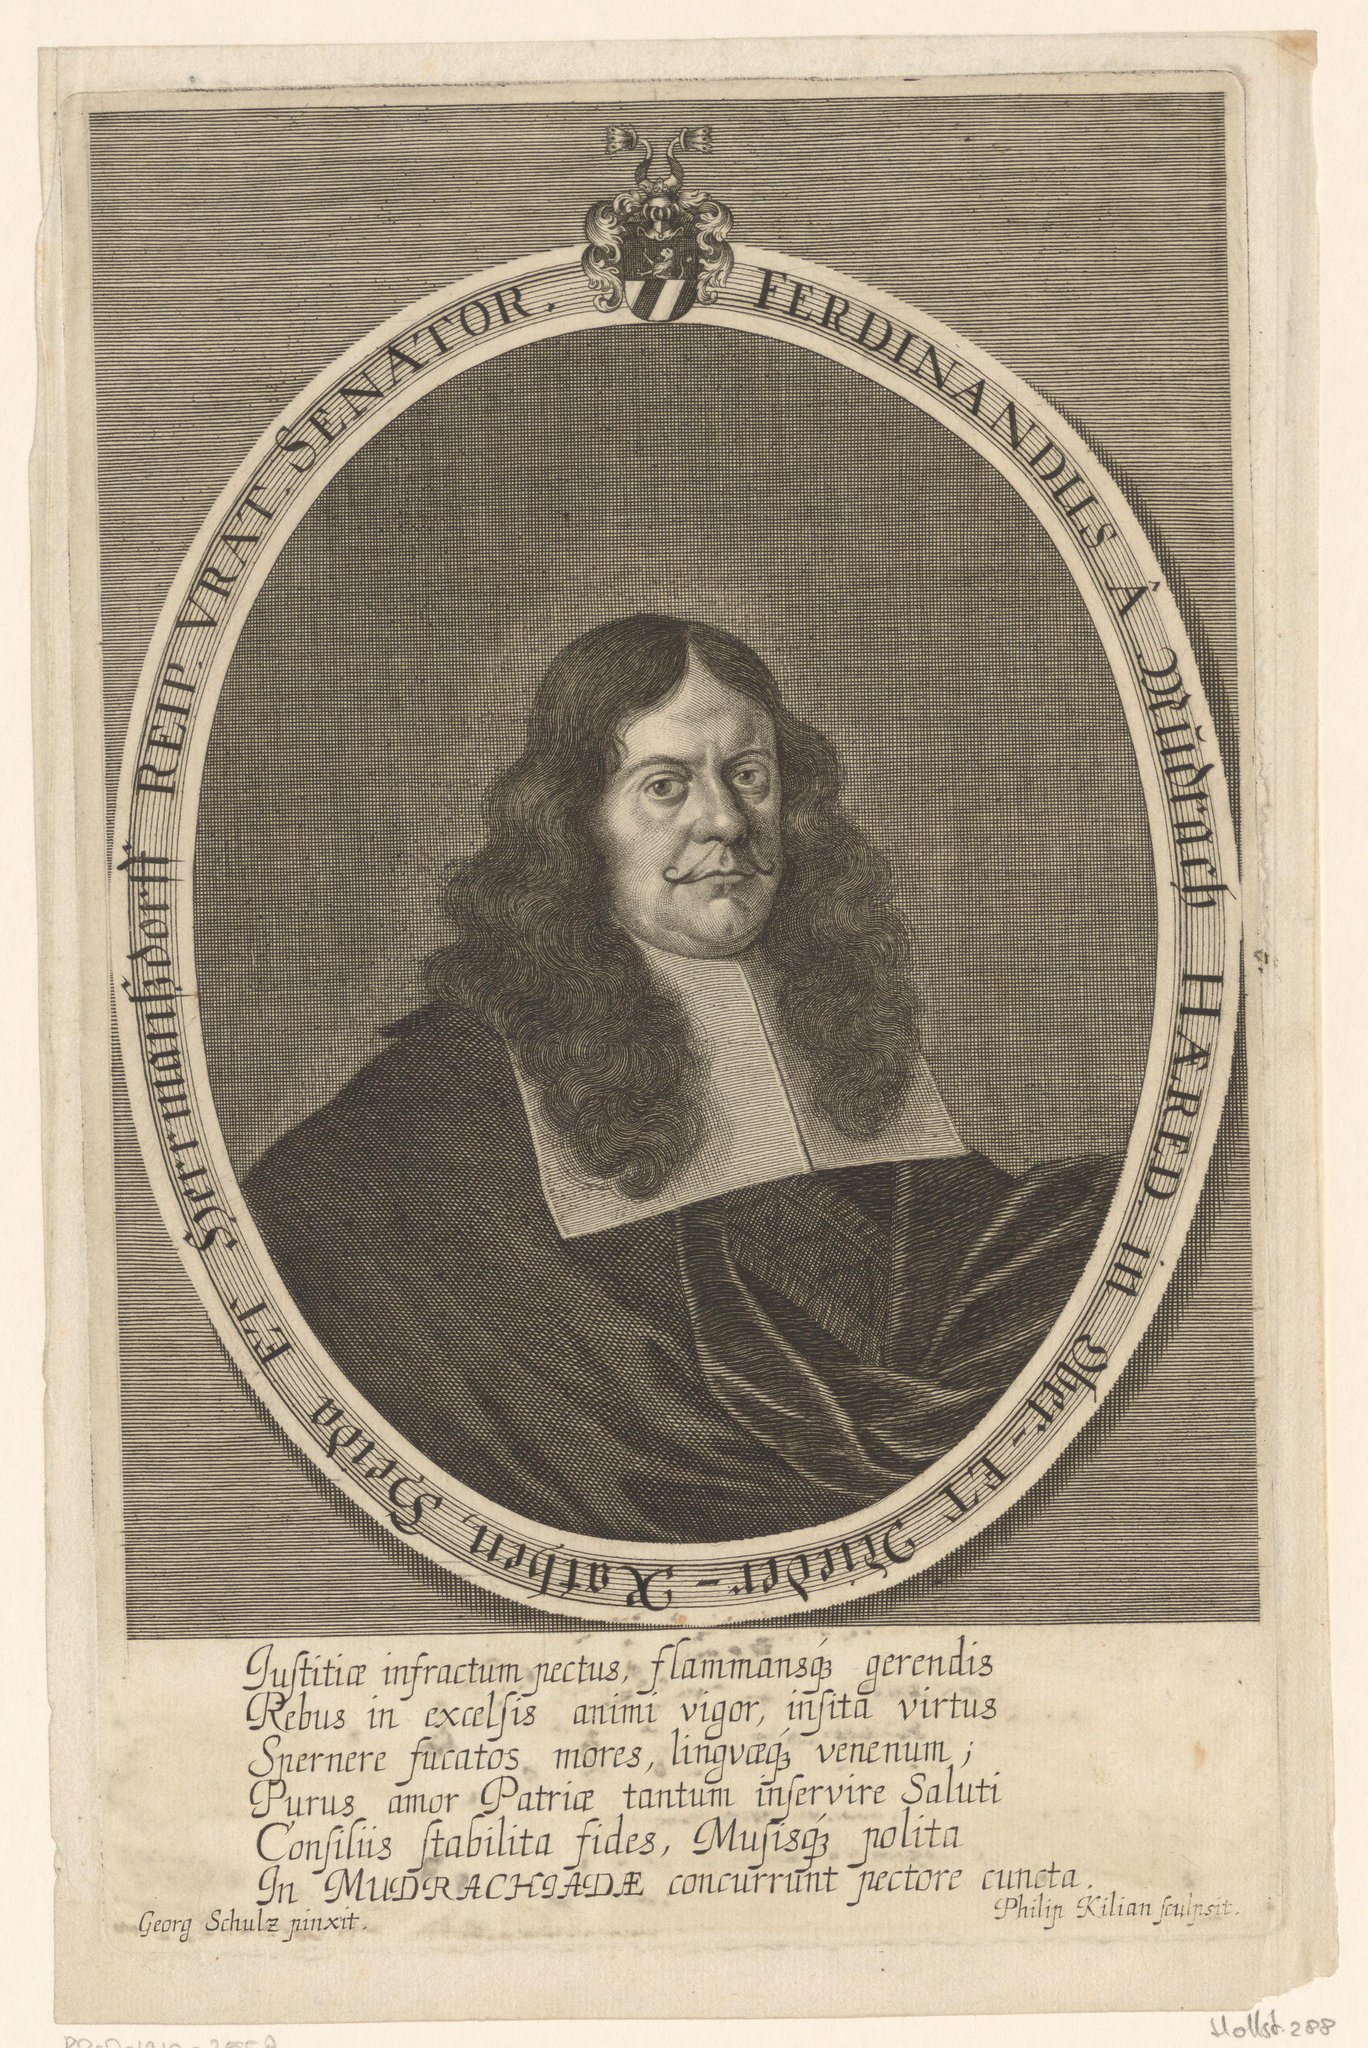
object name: print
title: Portret van Ferdinand von Mudrach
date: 1638-1693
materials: paper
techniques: engraving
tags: historical persons, lawyer, attorney at law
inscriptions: collector's mark: Lugt 2228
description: Tekst in het Latijn in de omlijsting en in de ondermarge.